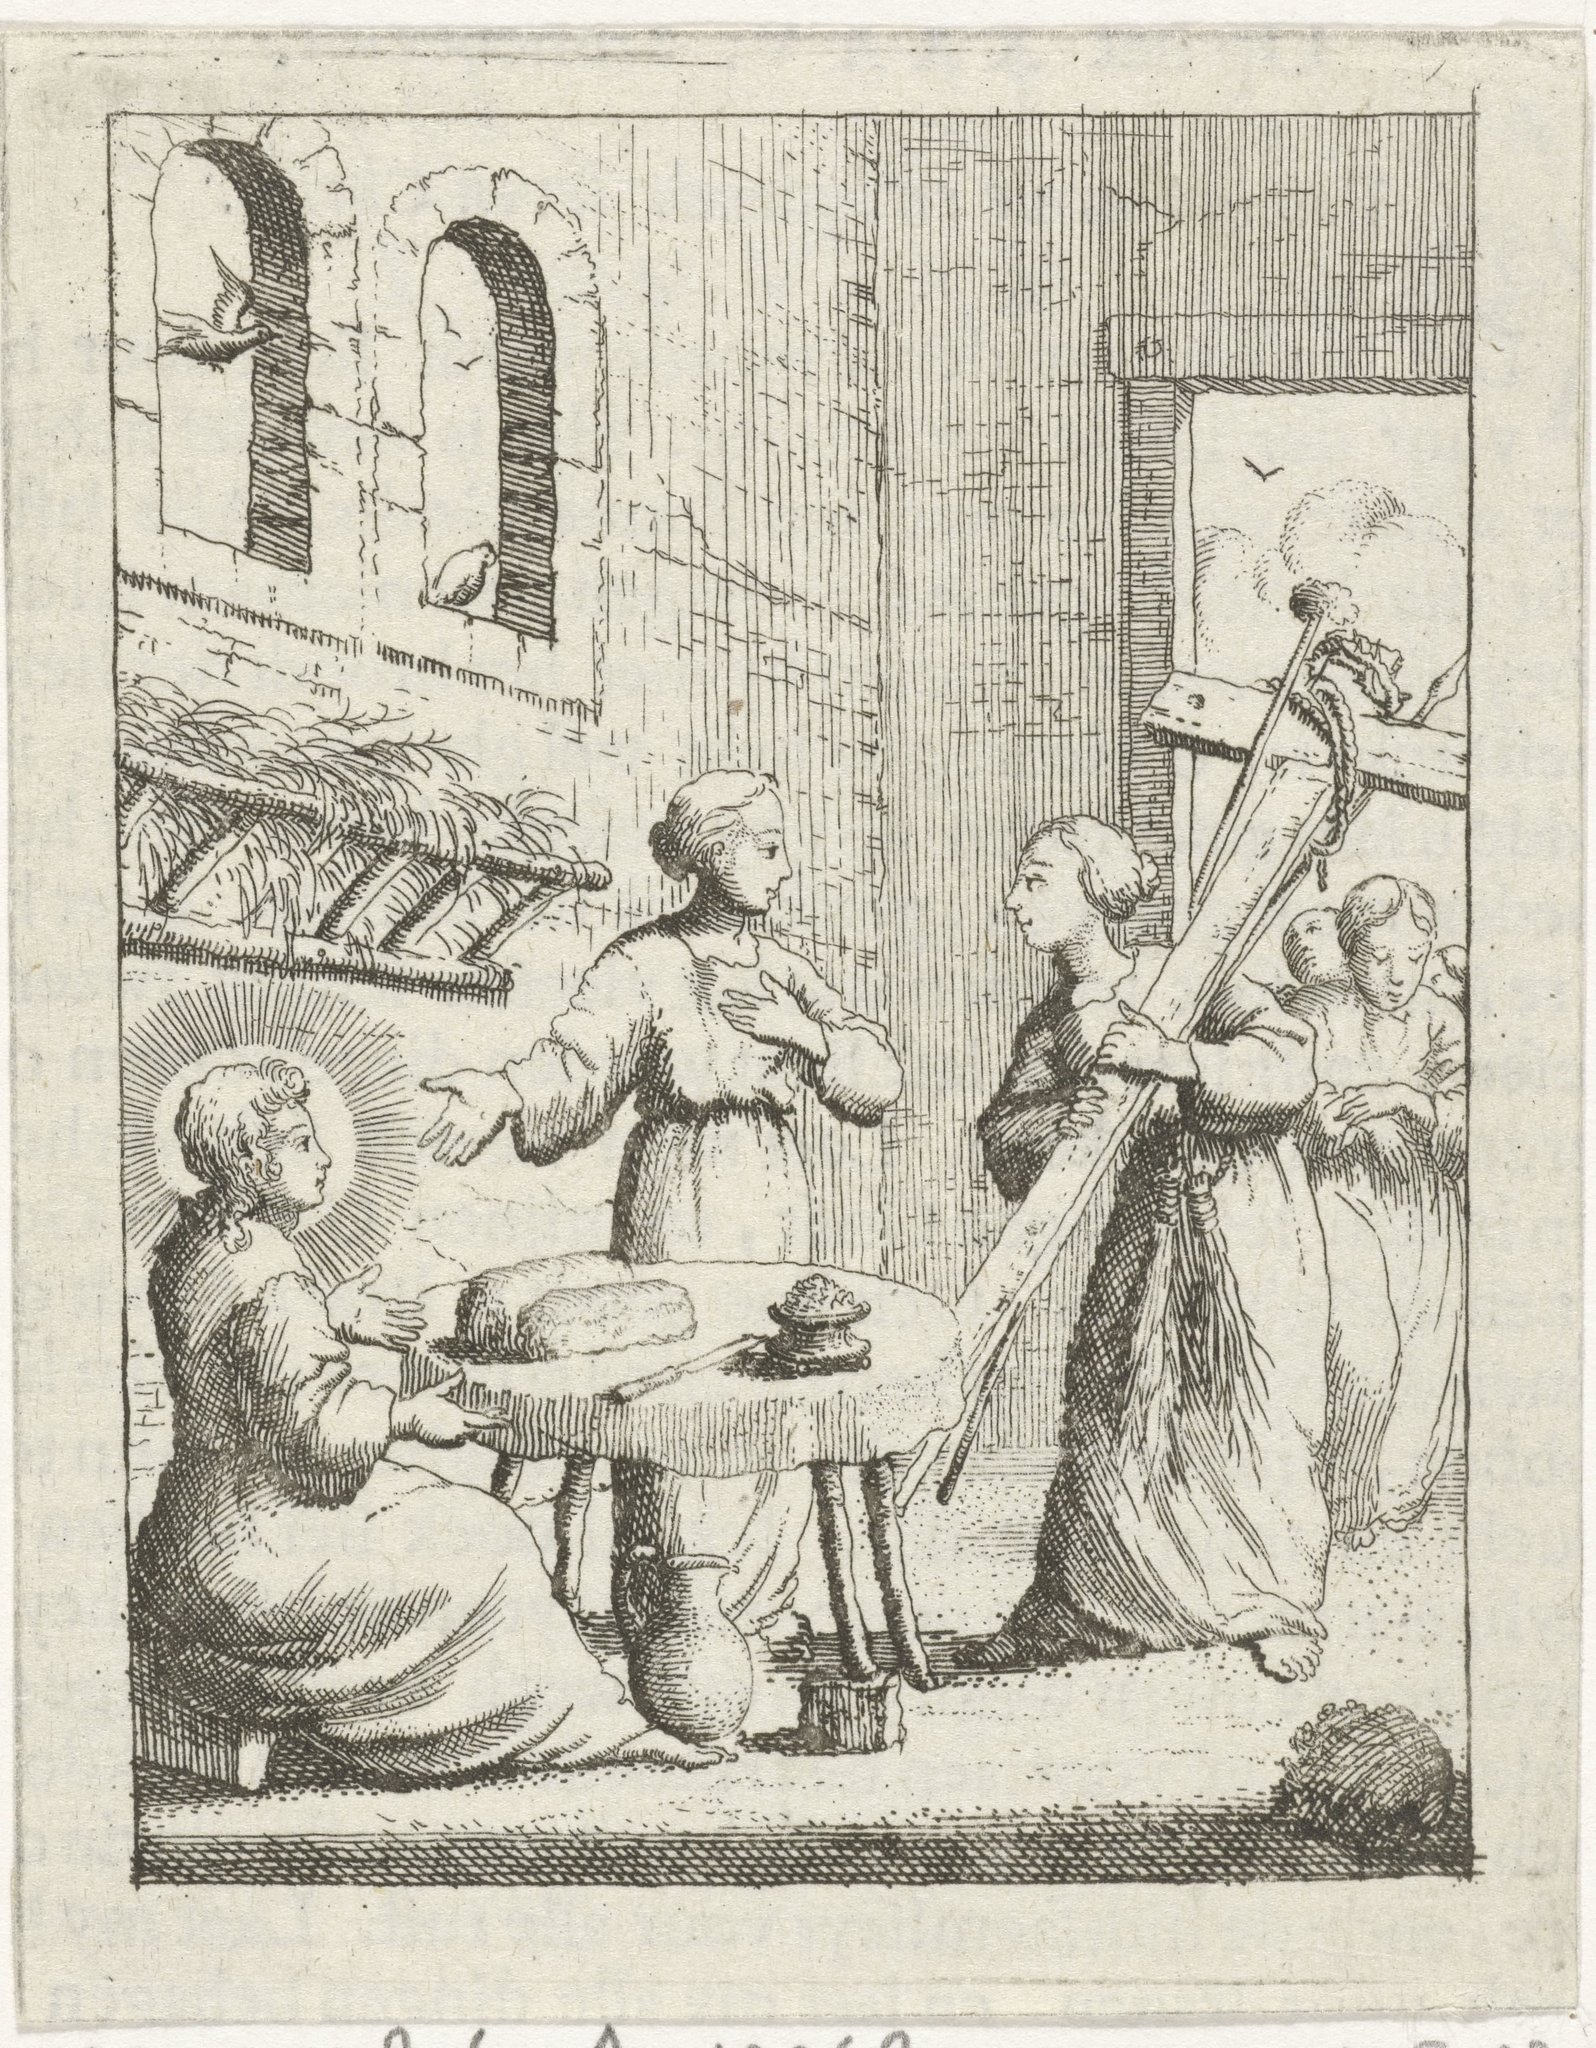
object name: print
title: Jezus in huis met de Ziel, aan welke het kruis wordt voorgehouden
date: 1678-1687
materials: paper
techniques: etching, letterpress printing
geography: amsterdam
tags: cross as symbol of christ, the soul, christ and the soul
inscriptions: collector's mark: Lugt 2228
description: Illustratie uit: Luyken, Jan. Jezus en de Ziel, 3 delen. Amsterdam: Pieter Arentsz II, 1678-1687. Tussen 1678-1744 verschenen van dit emblemataboek 10 edities.